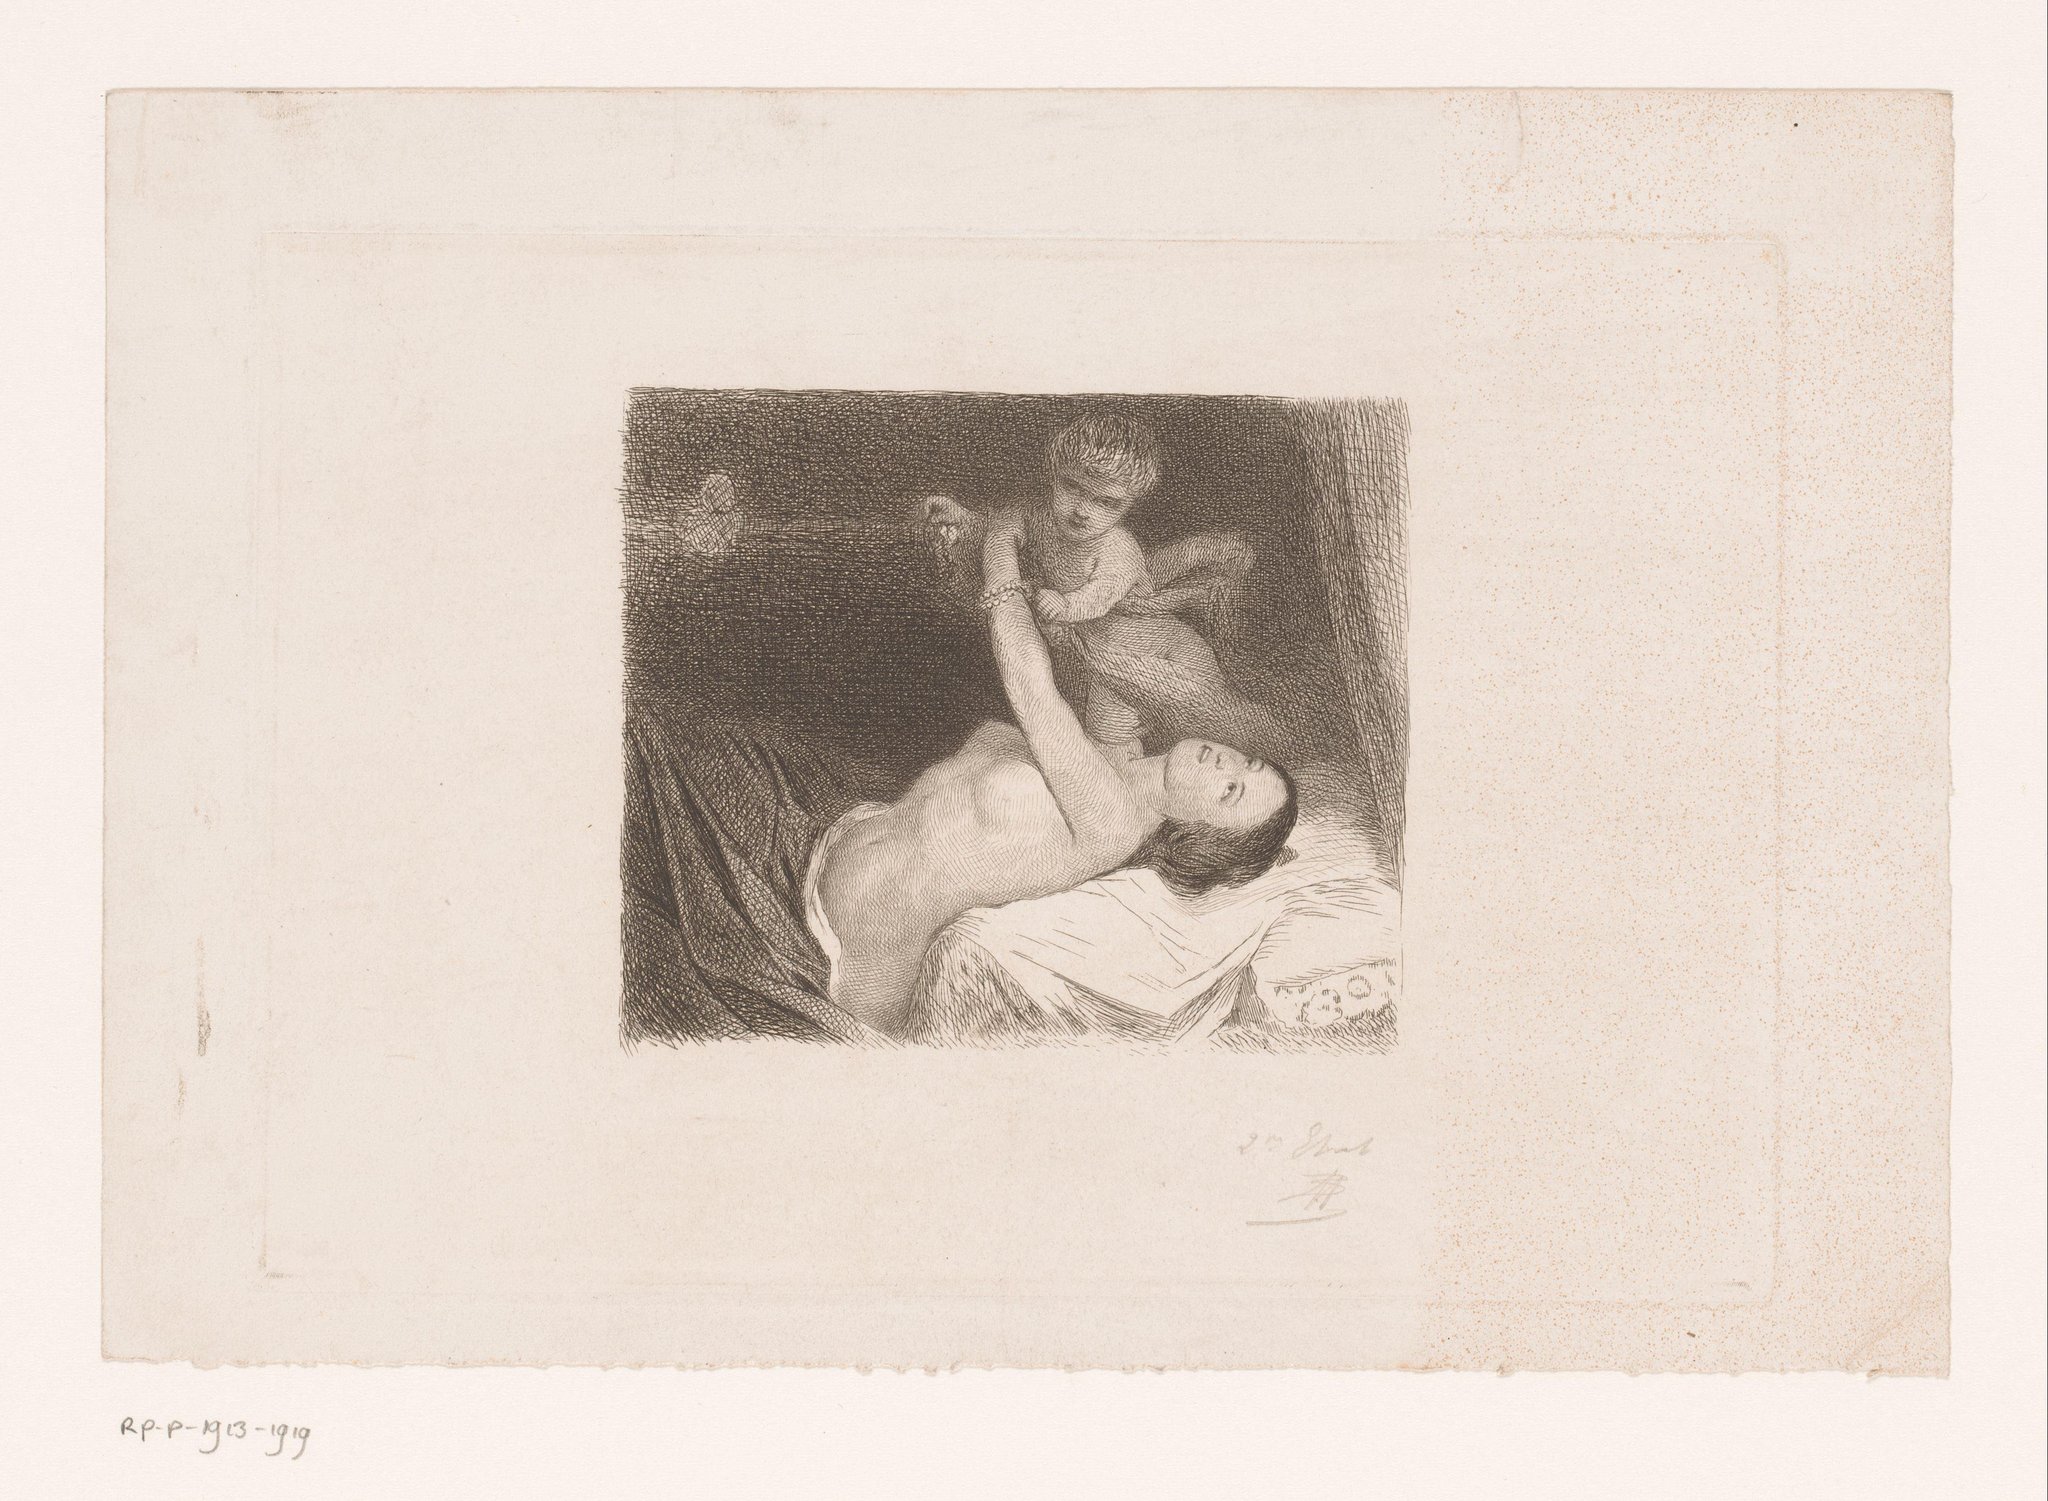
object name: print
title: Jonge vrouw en kind op bed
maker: jean baptiste pierre michiels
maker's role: print maker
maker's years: 1821-1890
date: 1831-1890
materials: paper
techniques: etching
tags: adolescent, young woman, maiden, mother and baby or young child, the (nude) human figure; 'corpo humano' (ripa) - aa - female human figure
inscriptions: inscription: ‘2e Etat’, collector's mark: Lugt 2228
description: Mogelijk gaat het om een voorstelling van Amor en Psyche.